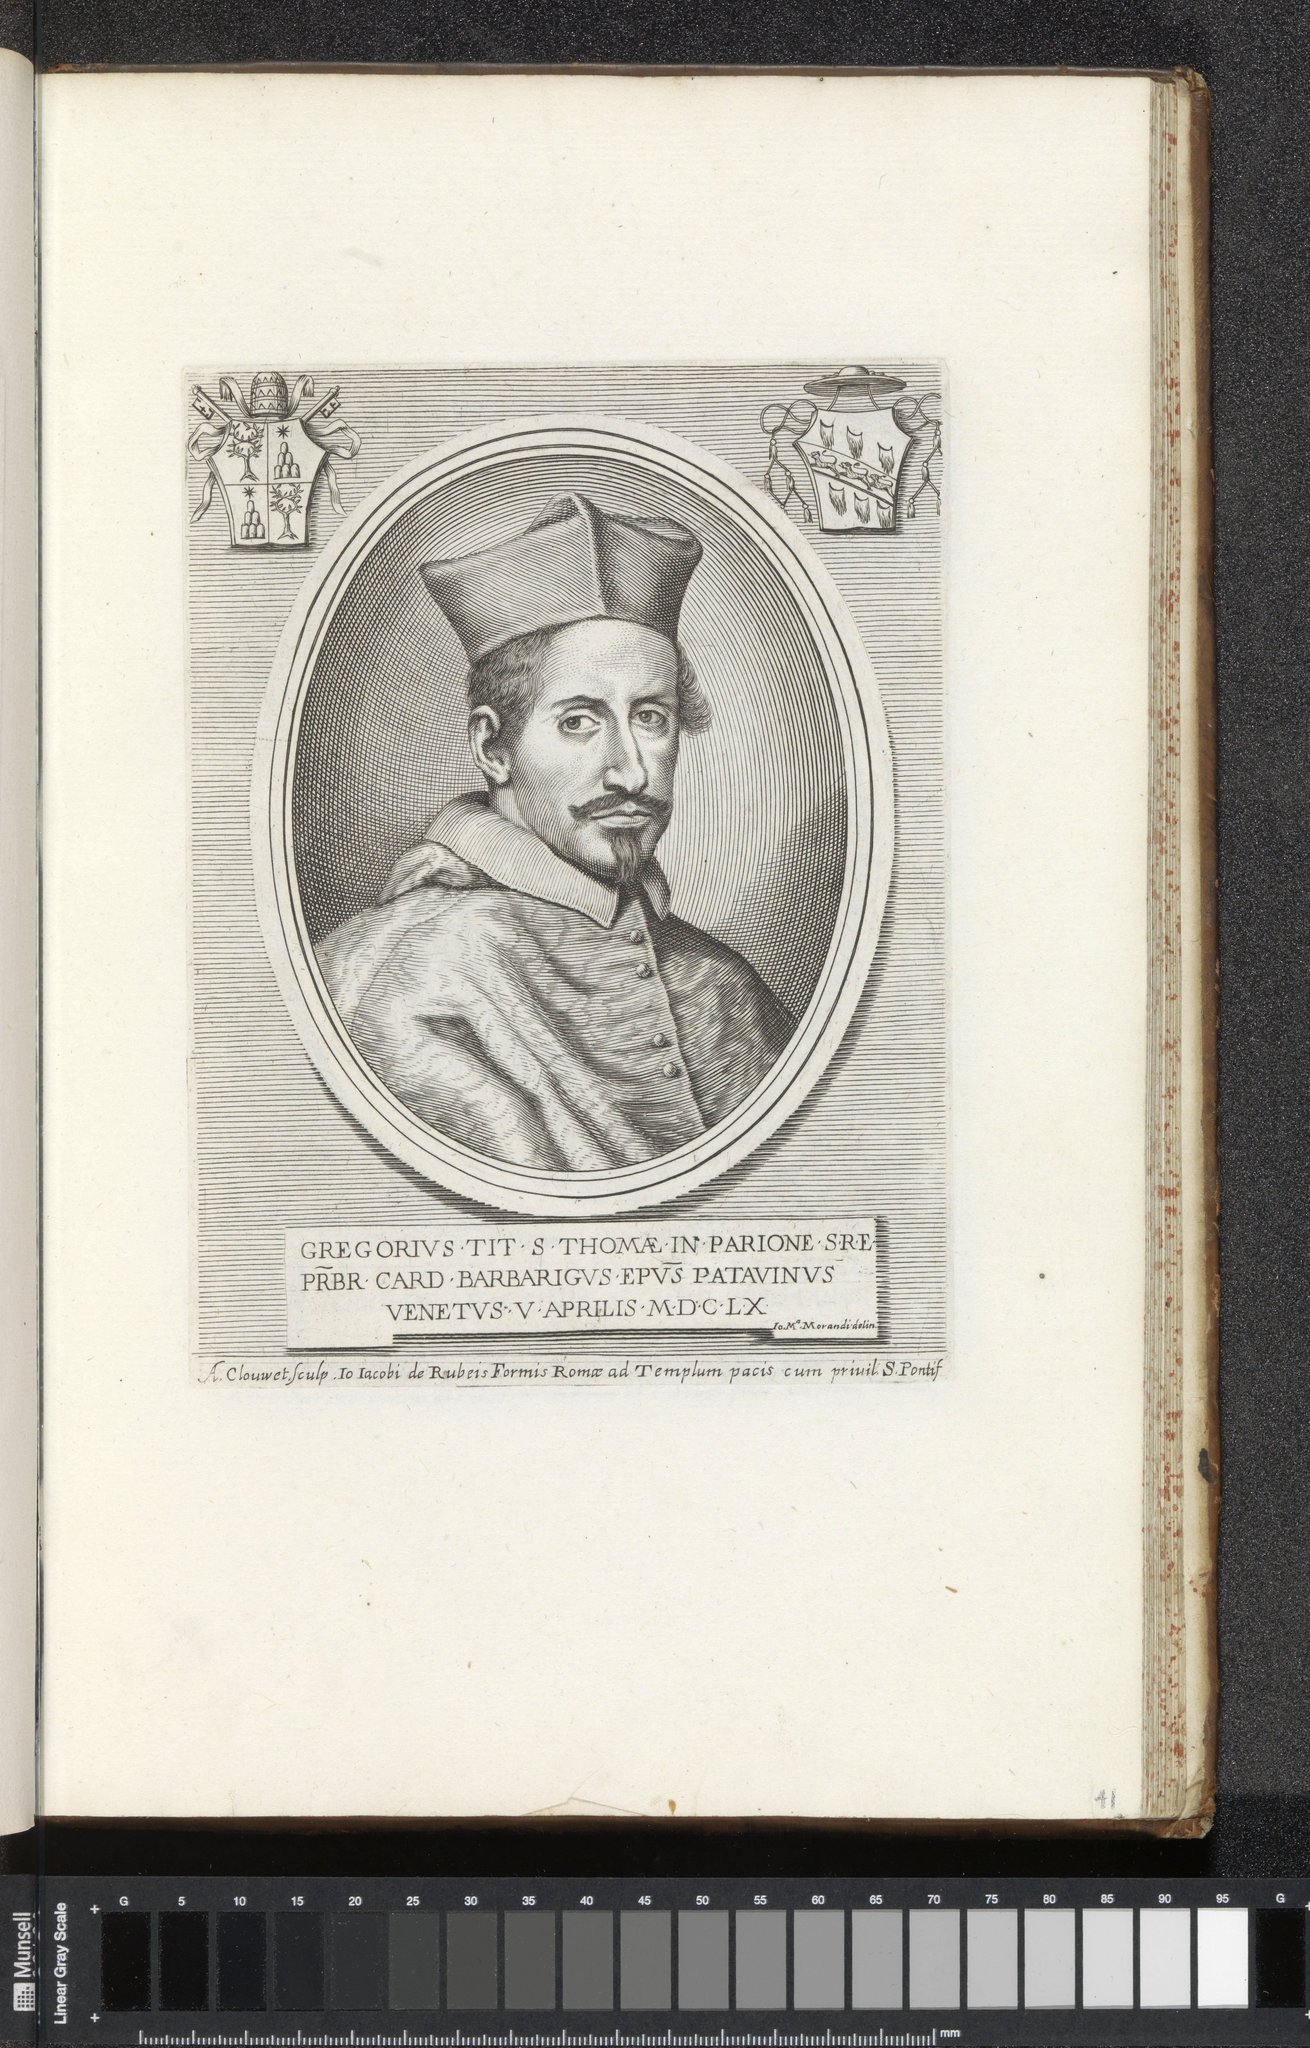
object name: print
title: Effigies Nomina et Cognomina S.D.N. Alexandri Papae VII et RR. DD. SRE. Cardd (...).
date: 1660-1679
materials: paper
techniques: engraving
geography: rome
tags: venice, cardinal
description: Portret van kardinaal Gregorio Barbarigo. Linkboven het wapen van paus Alexander VII en rechtsboven het wapen van de kardinaal. Onderaan een onderschrift in het Latijn. De prent maakt deel uit van een album.